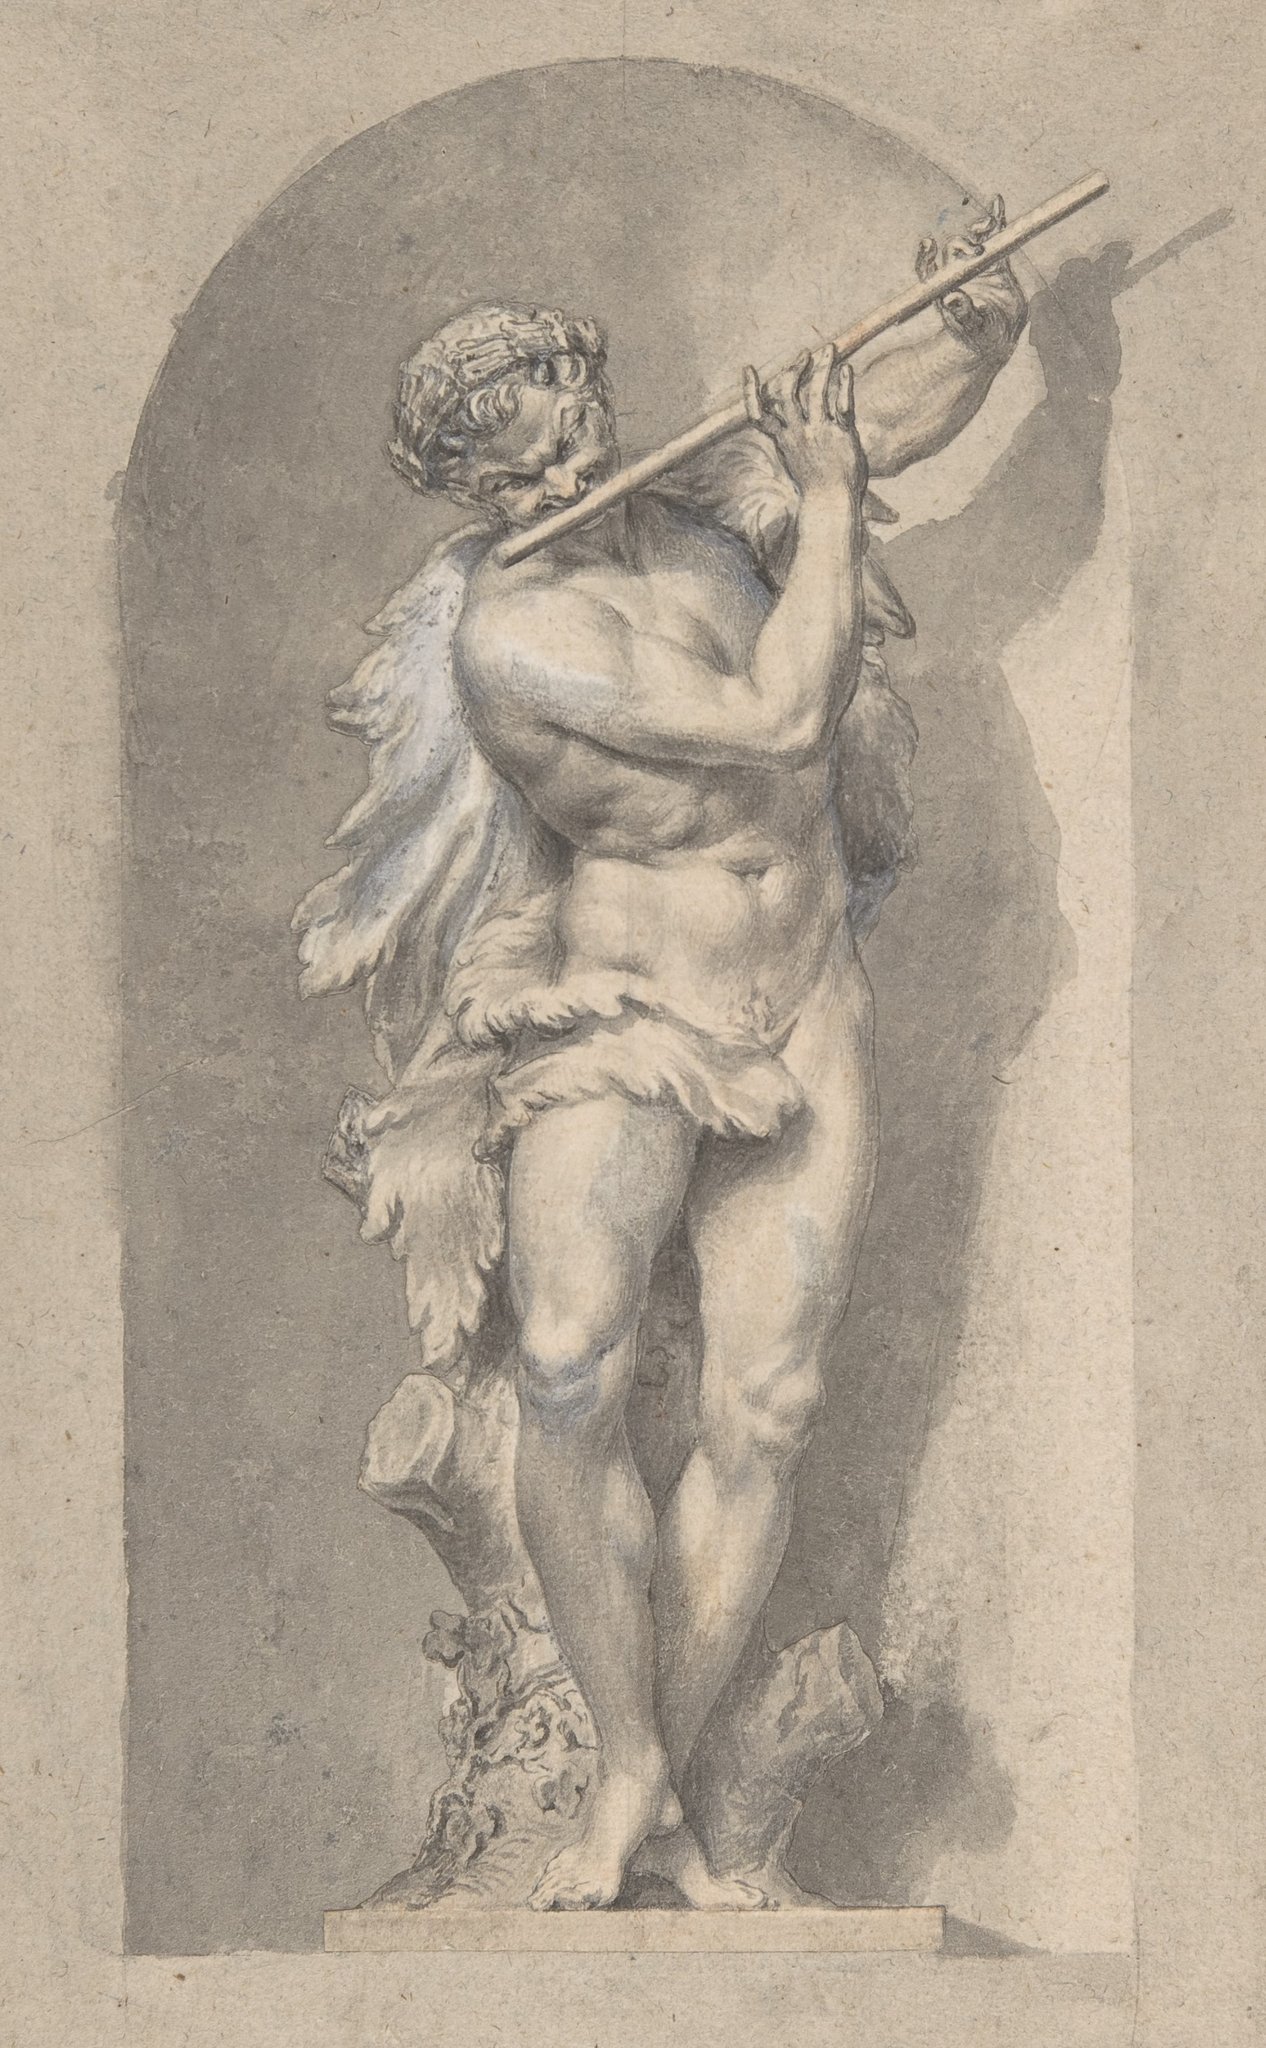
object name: drawing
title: Silhouetted Study of Pan in a Niche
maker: anonymous, italian, 18th century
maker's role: artist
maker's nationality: italian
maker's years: 1700-1800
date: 1701-1800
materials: chalk, gouache, ink, paper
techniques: brush, cutting, drawing, highlighting, pen, wash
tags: flutes,pan